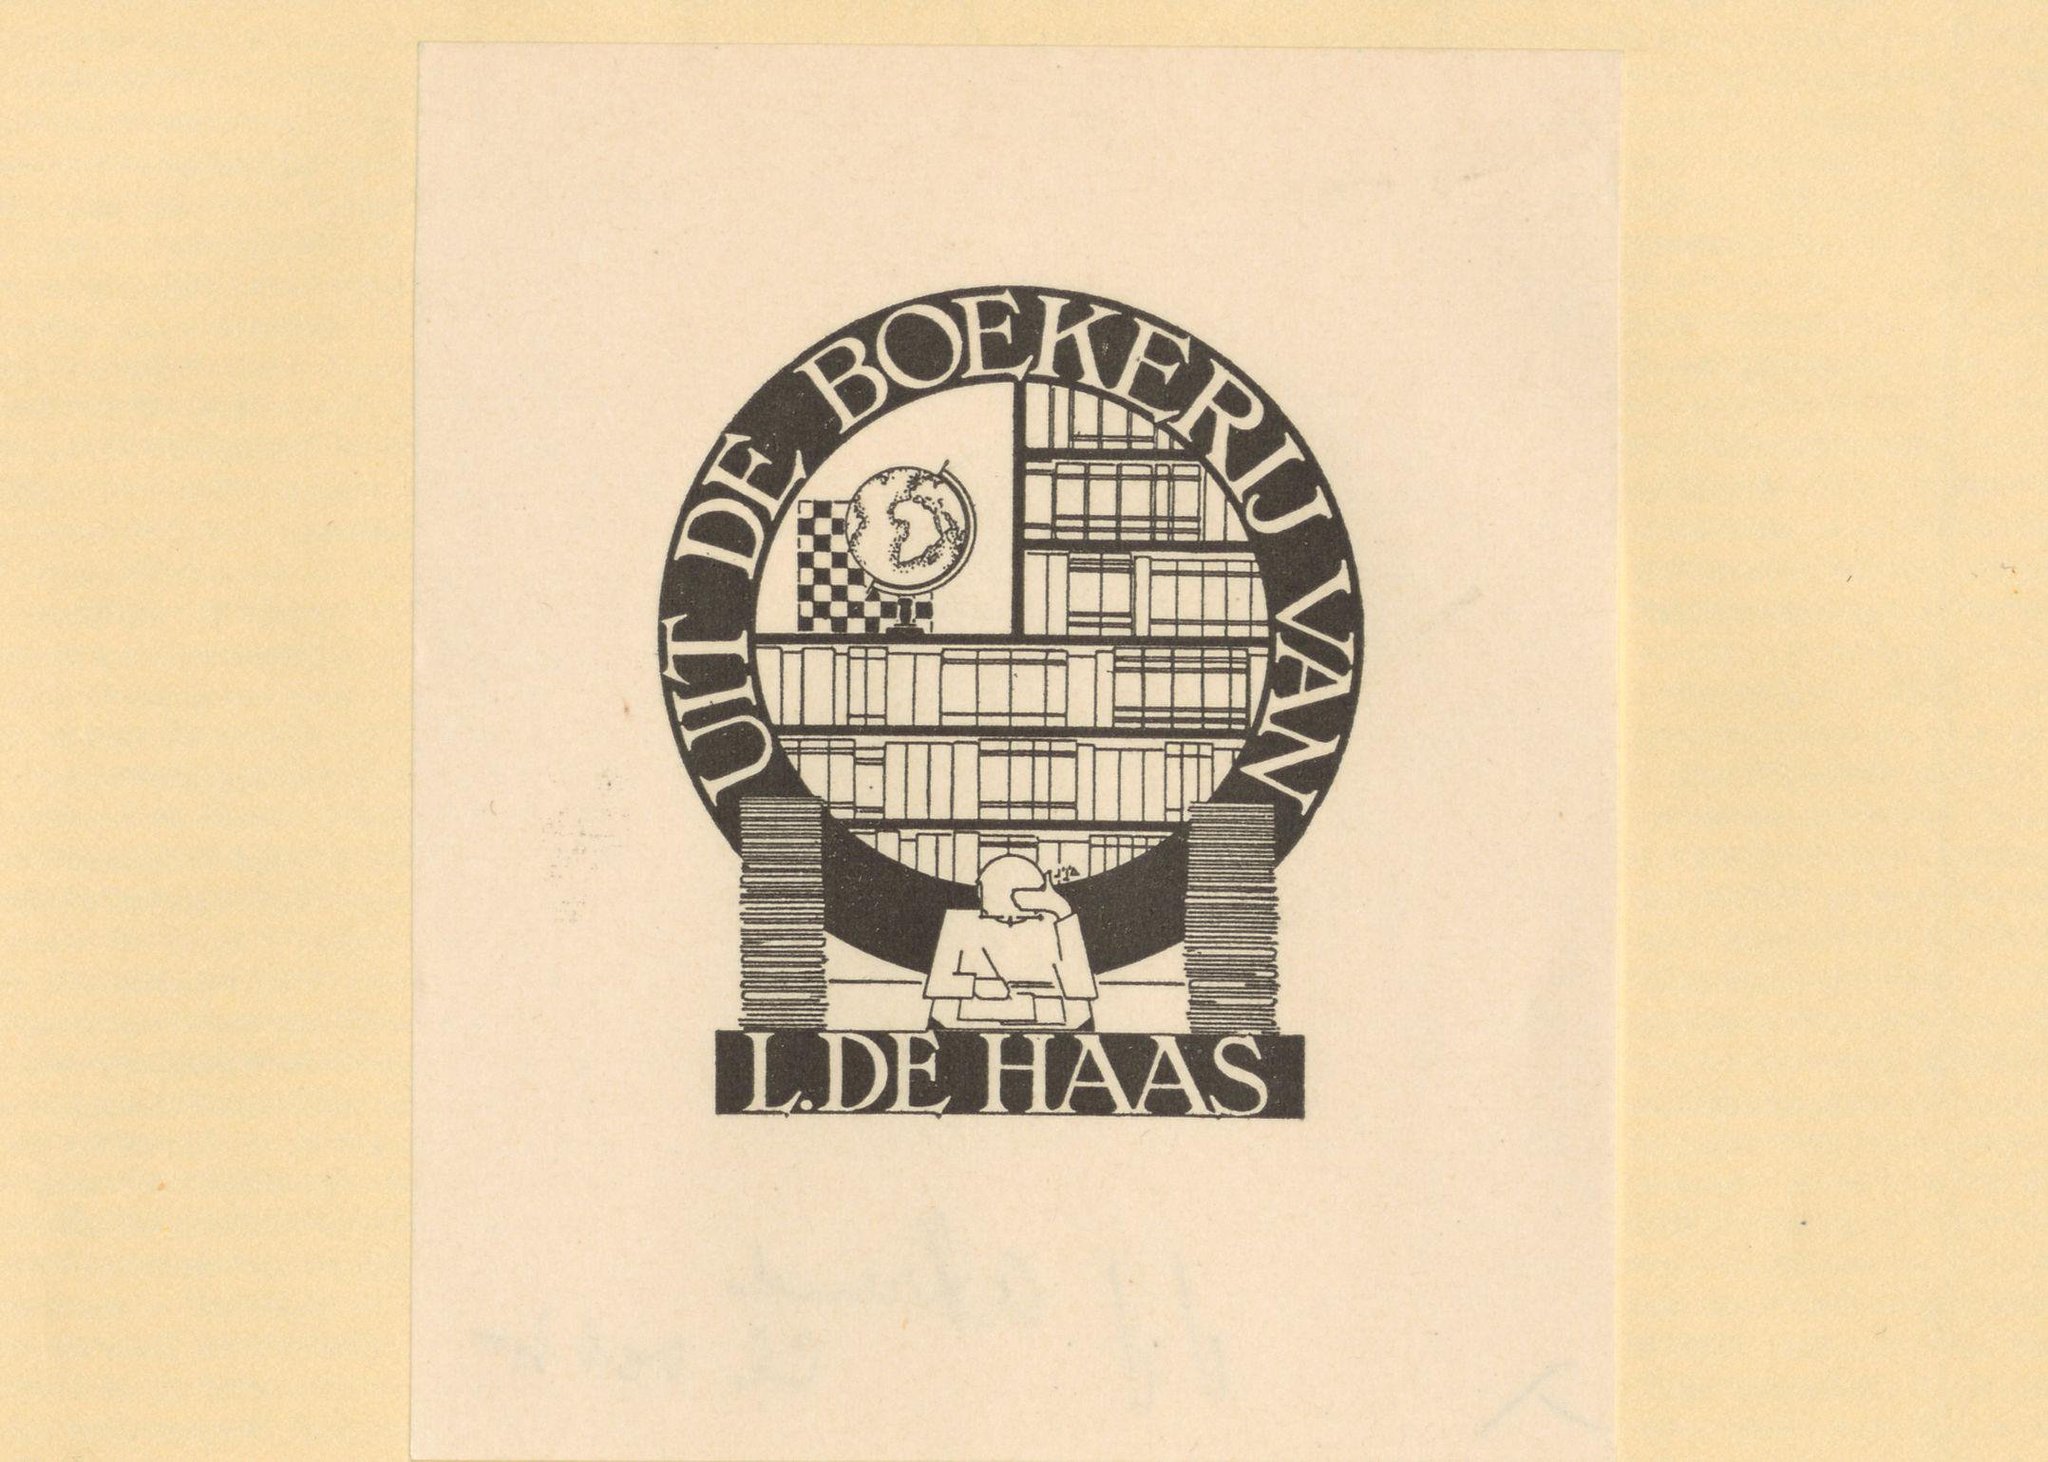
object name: bookplate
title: Ex libris van L. de Haas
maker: Anonymous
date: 1940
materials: paper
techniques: printing block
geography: netherlands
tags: bookshelves, sitting figure, globe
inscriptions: inscription: ‘J.J. Arend Cl vel (?) 35’